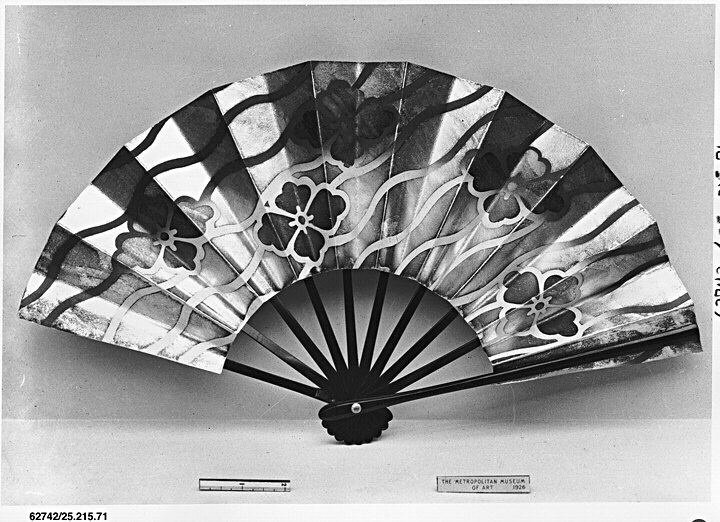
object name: folding fan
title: Fan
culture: japanese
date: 1901-2000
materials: metal, paint, paper